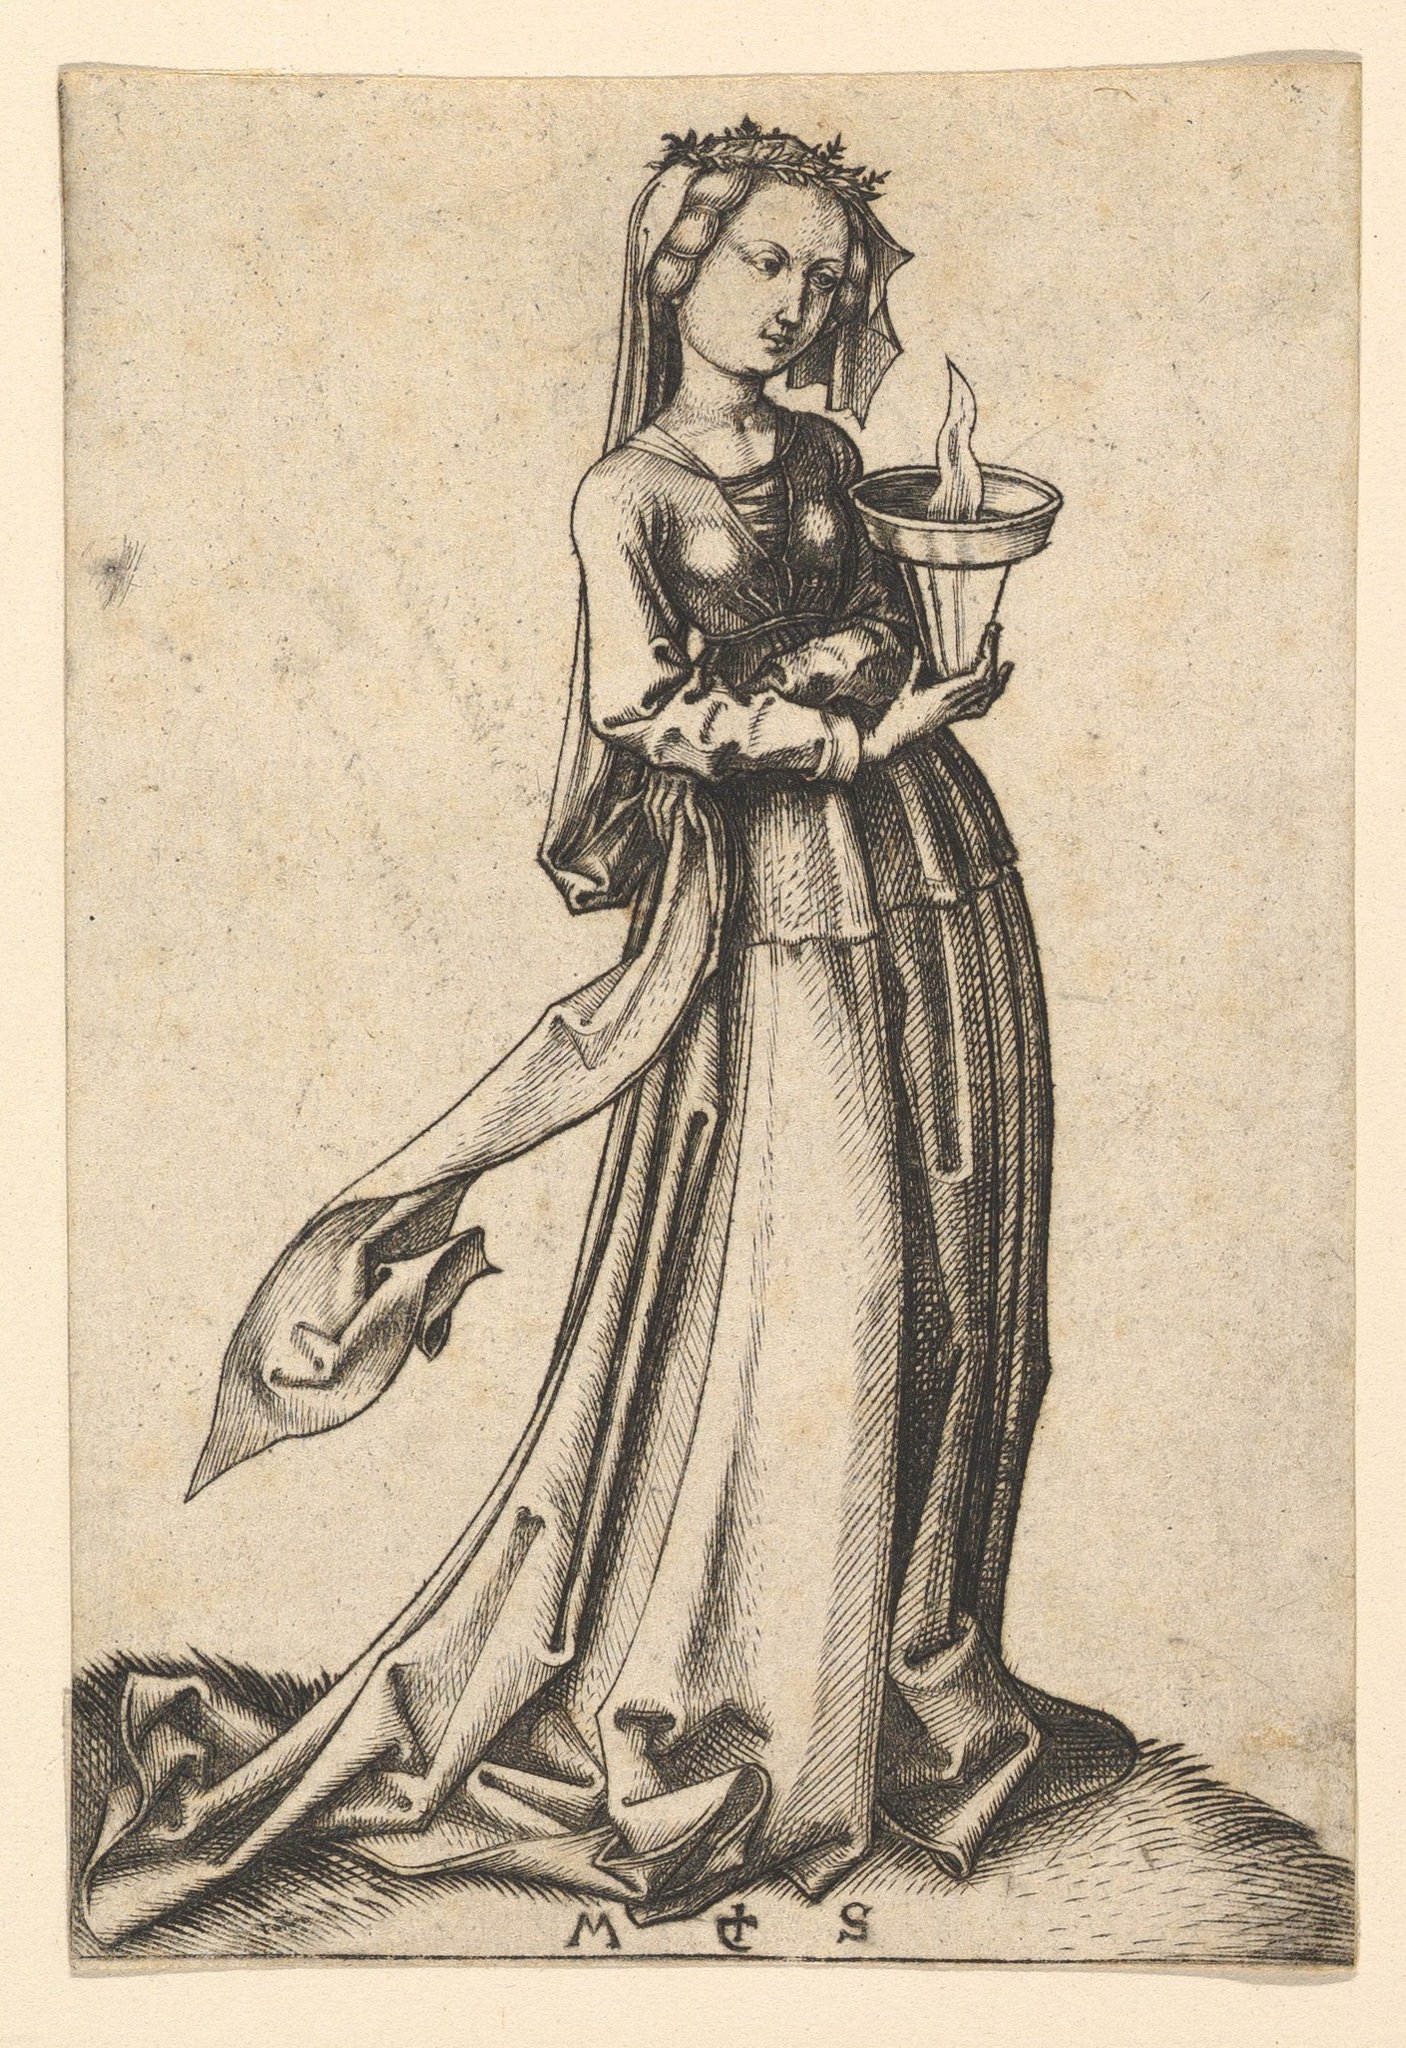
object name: print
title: The Fourth Wise Virgin, from the series The Wise and Foolish Virgins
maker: martin schongauer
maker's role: artist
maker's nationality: german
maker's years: 1430-1491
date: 1470-1491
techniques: engraving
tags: virgin mary